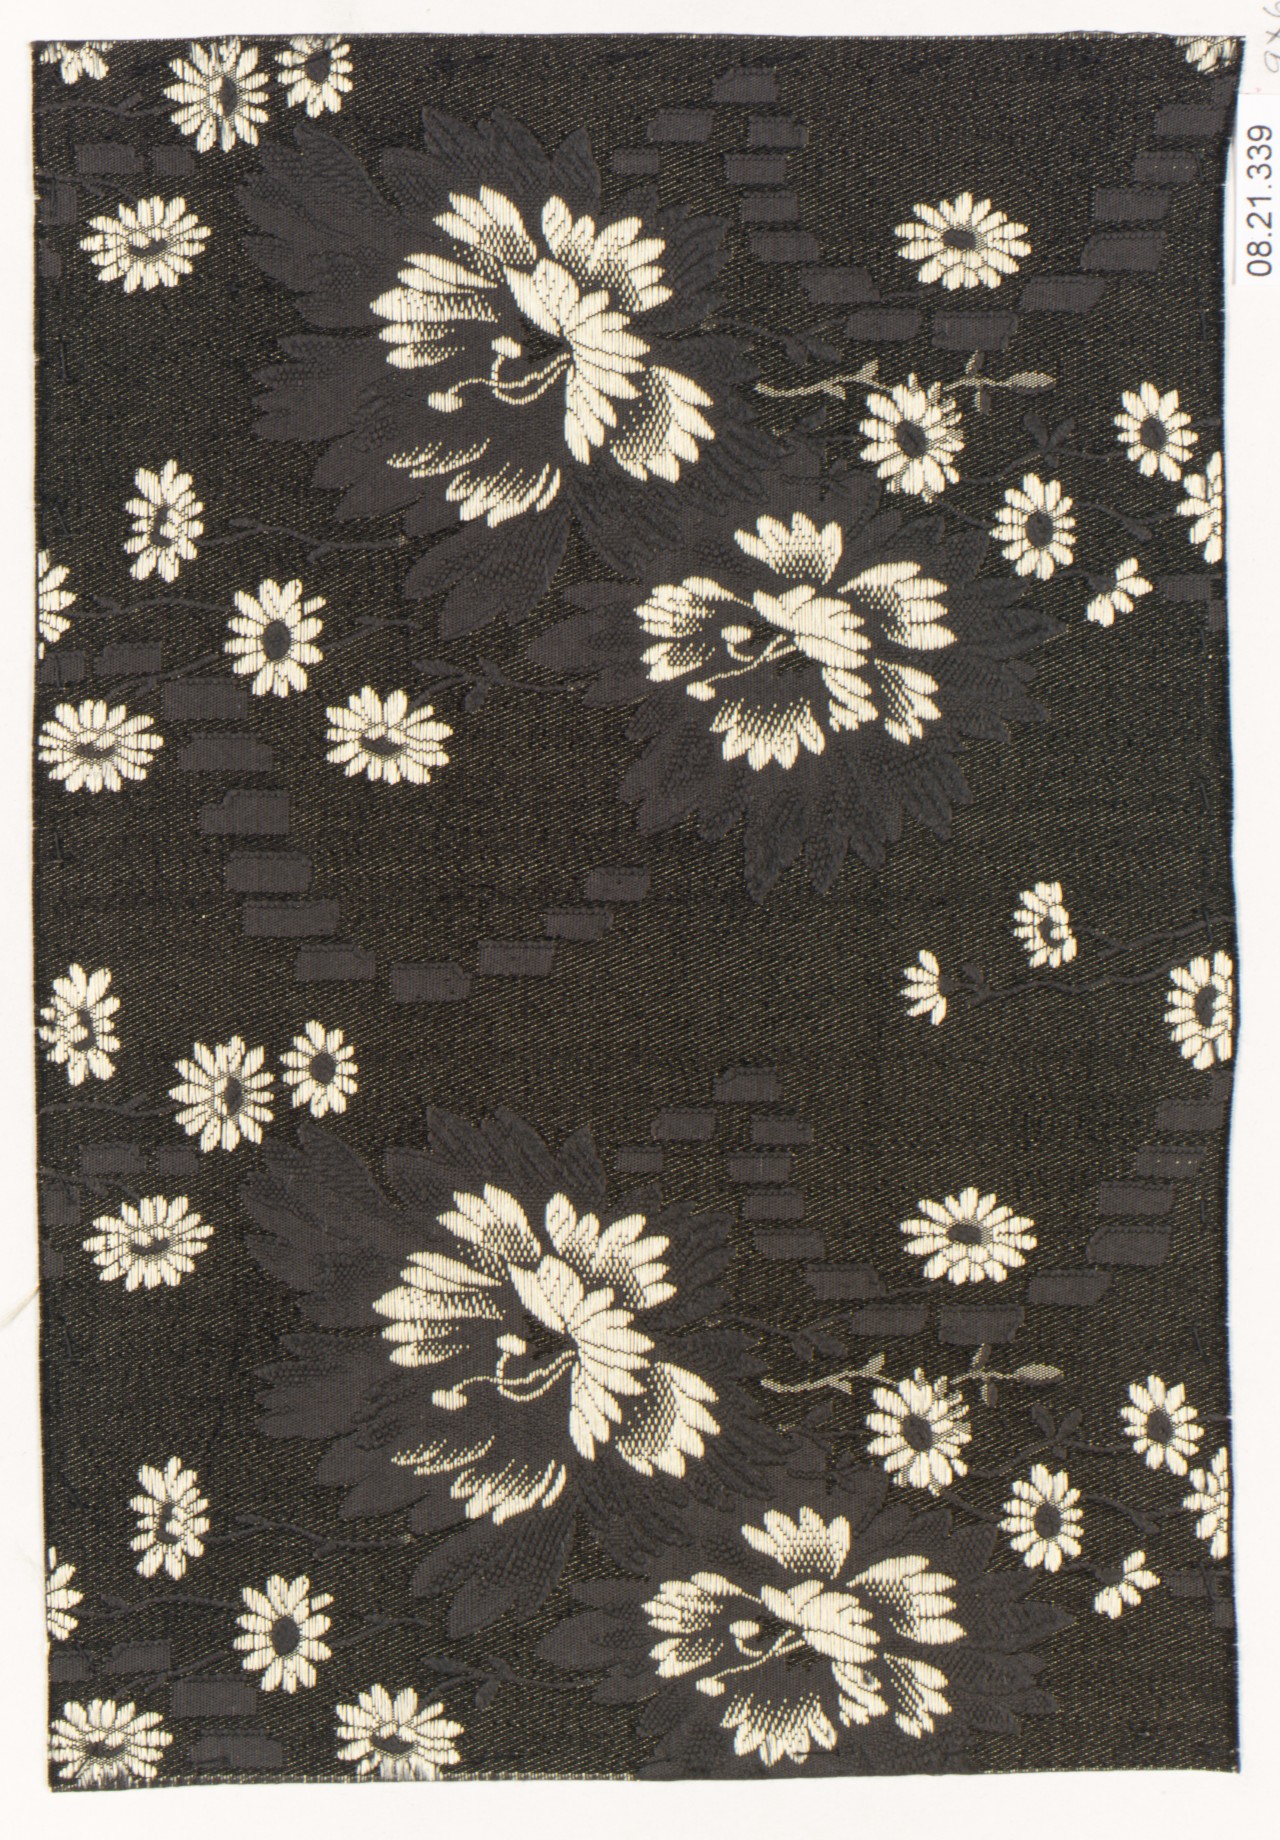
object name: textile sample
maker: Anonymous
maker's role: designer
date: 1900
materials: silk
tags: flowers